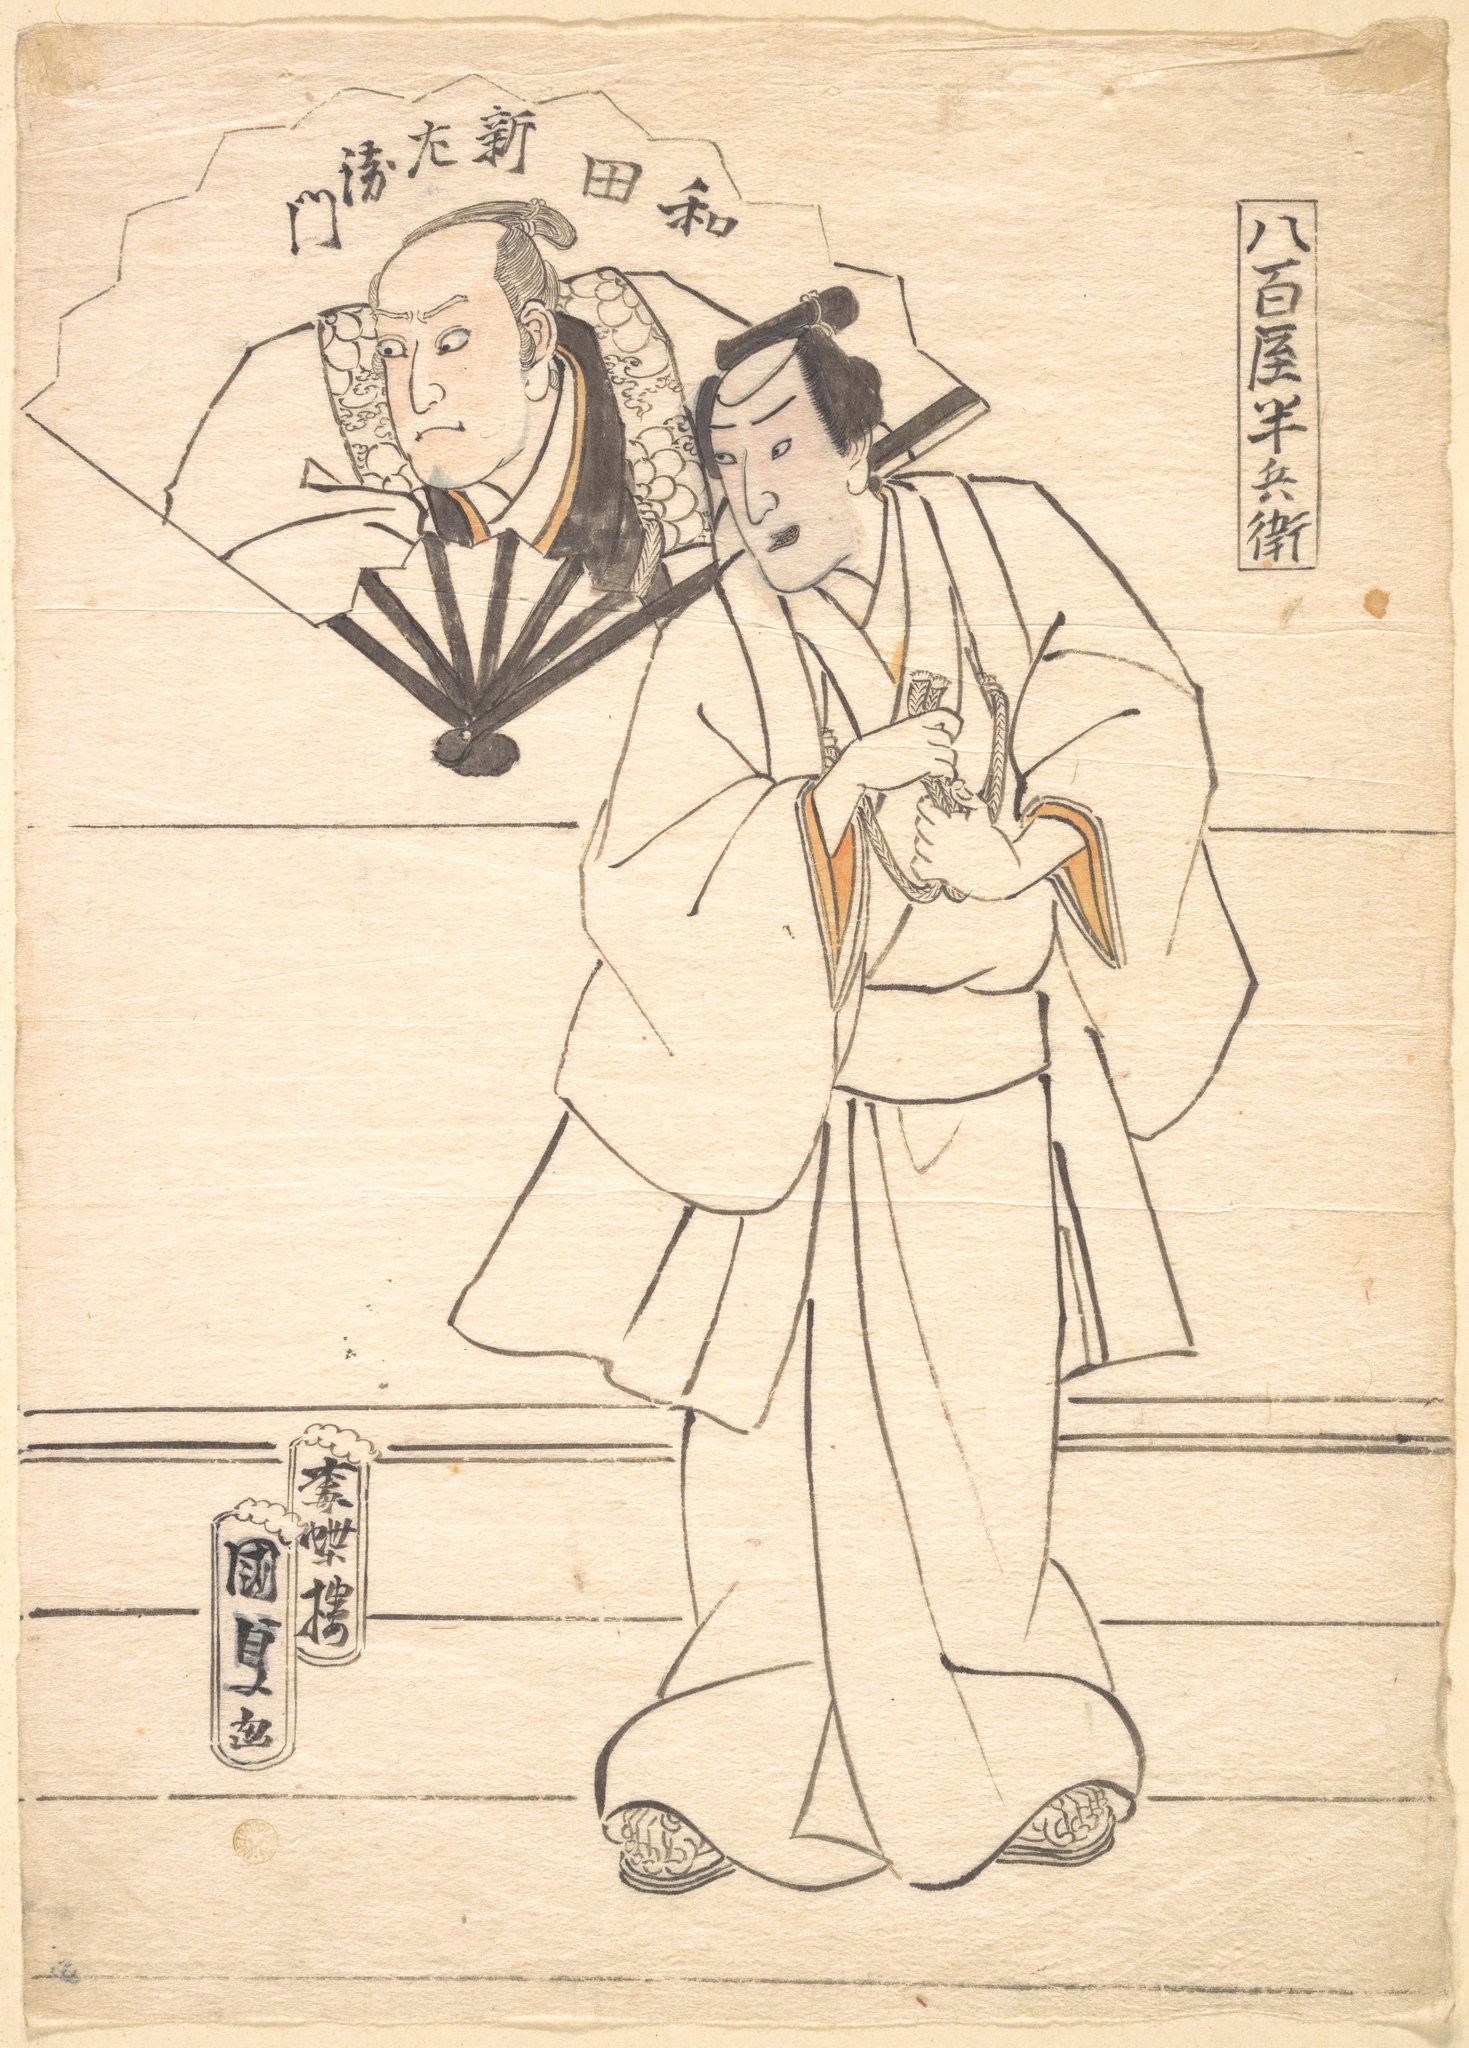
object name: print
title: Drawing Intended as Design for an Actor Print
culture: japanese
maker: utagawa kunisada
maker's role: artist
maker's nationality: japanese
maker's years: 1786-1864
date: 1833-1847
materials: ink, paper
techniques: woodblock print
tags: fans,men,portraits